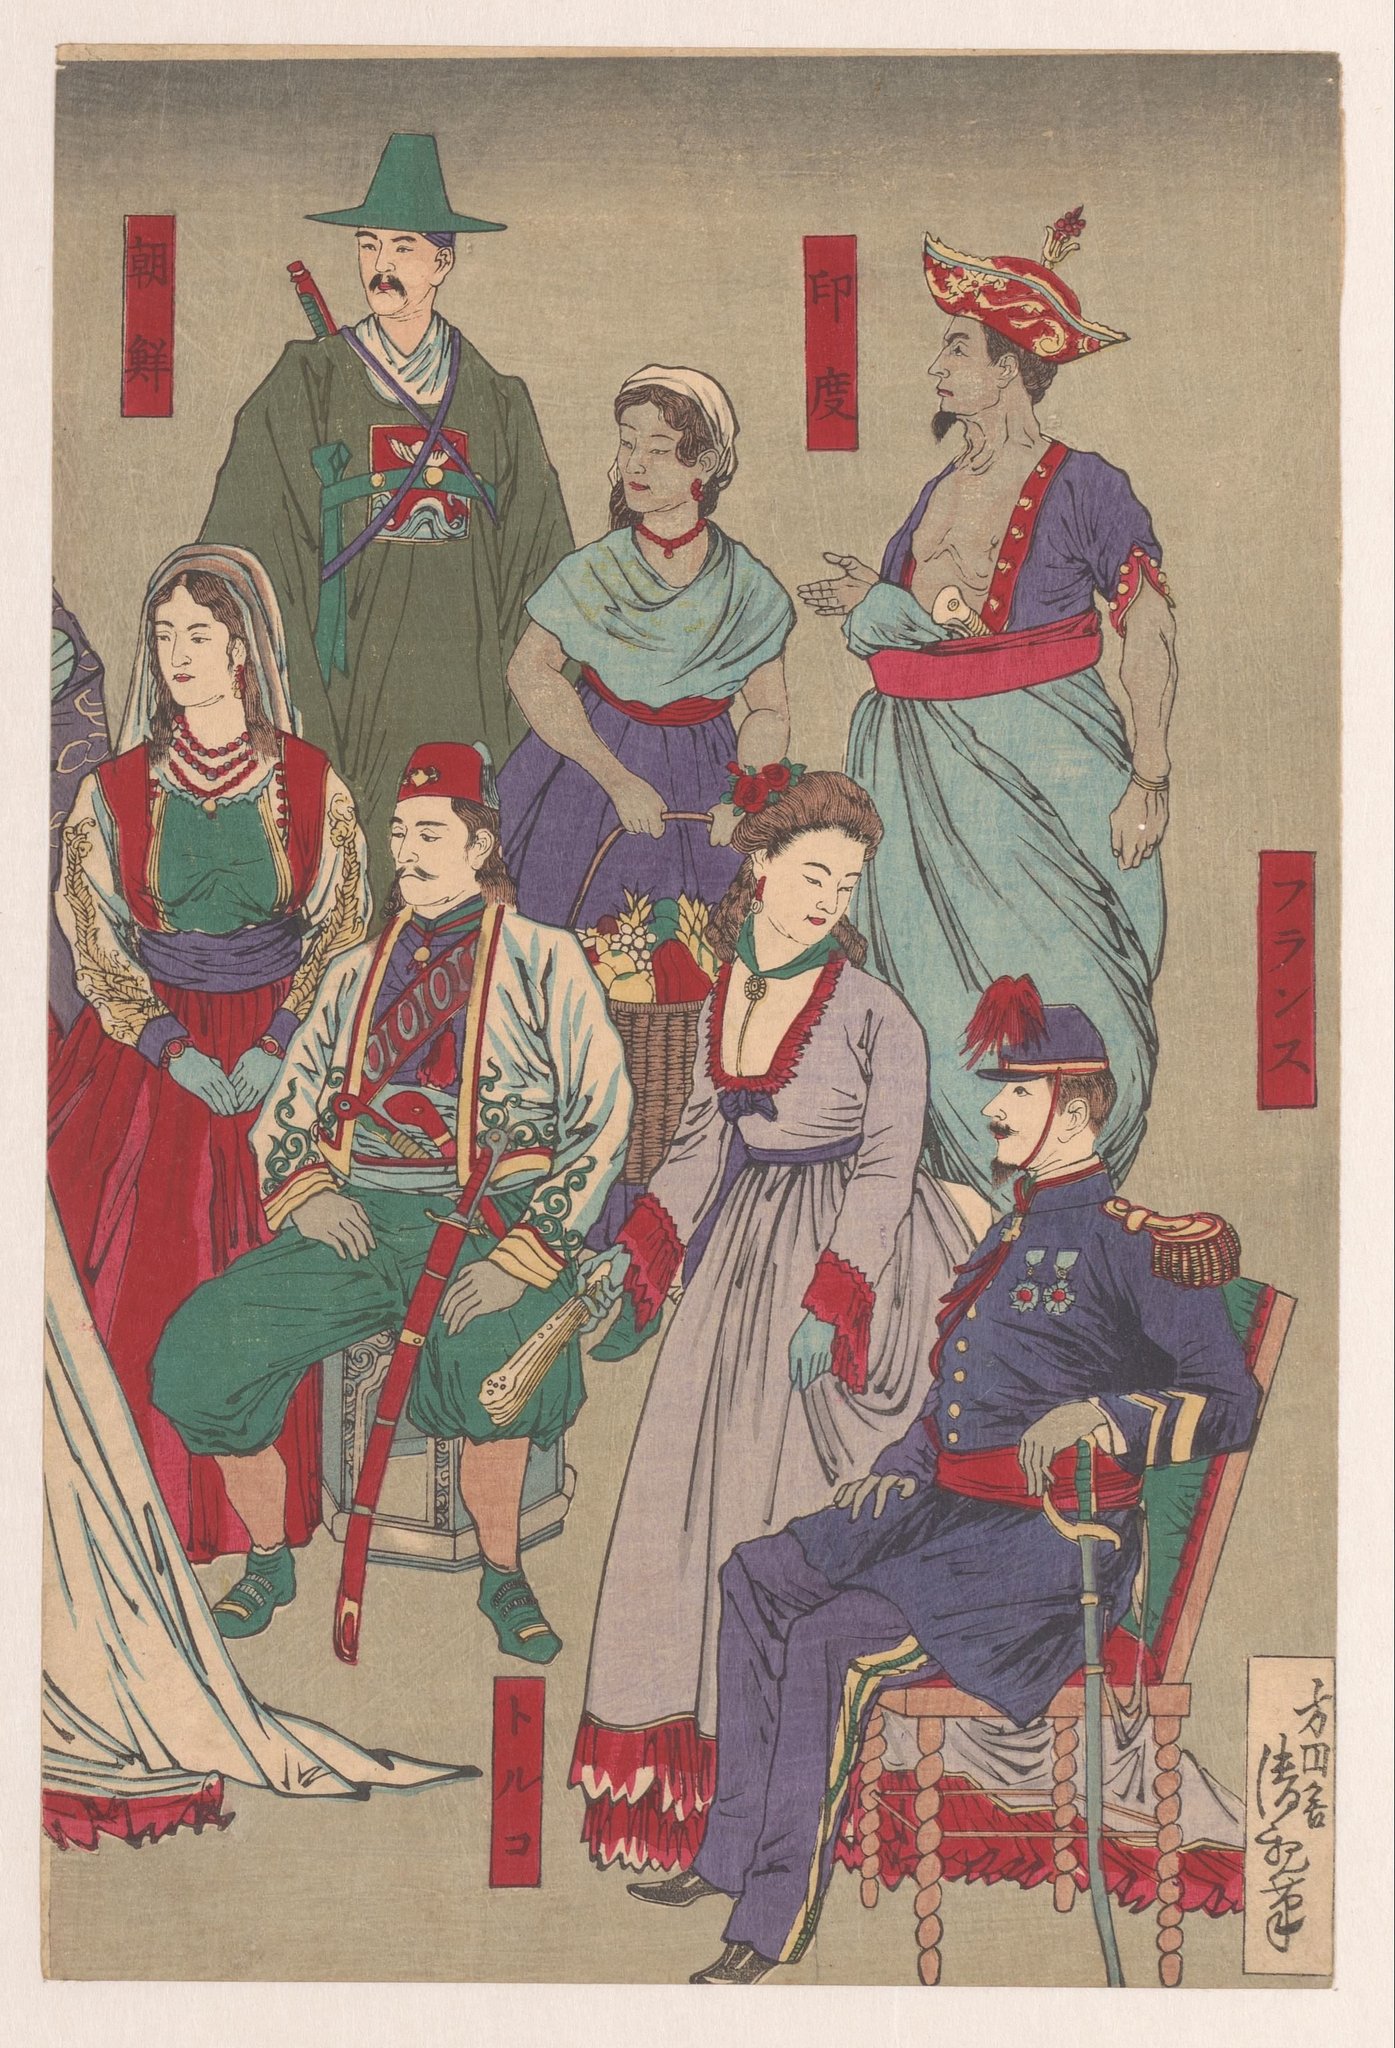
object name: print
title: Weergave van klederdracht in alle landen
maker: kobayashi kiyochika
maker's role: print maker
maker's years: 1847-1915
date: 1882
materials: paper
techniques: woodcut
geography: japan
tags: human types; peoples and nationalities, folk costume, regional costume